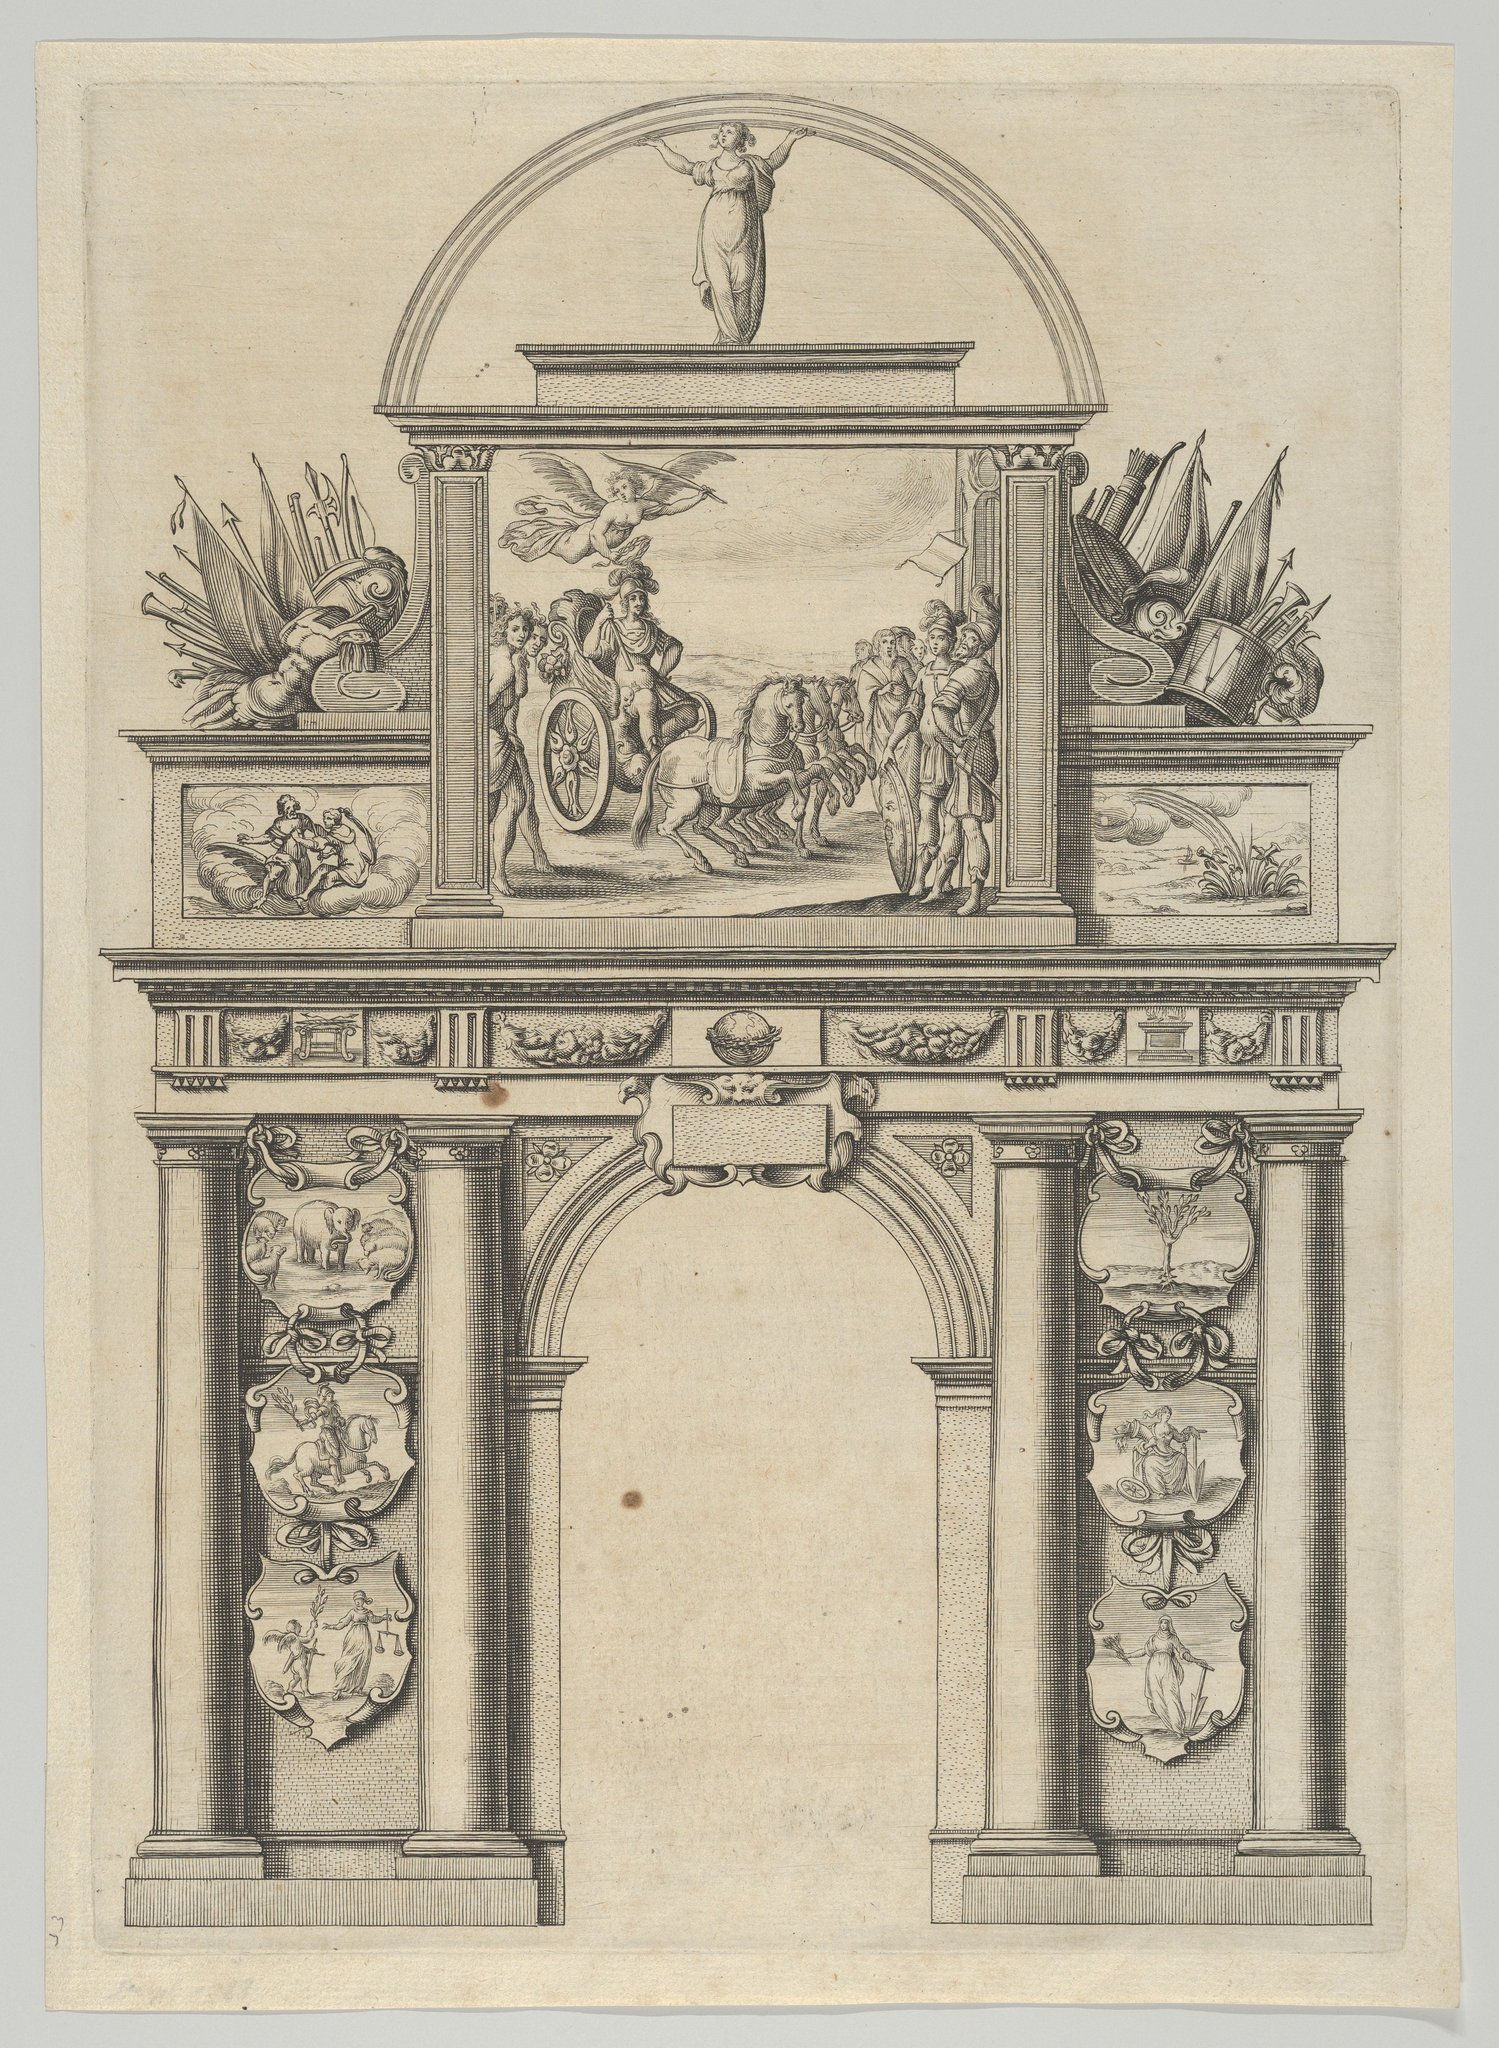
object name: print, fete, ornament architecture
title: Triumphal arch, from 'Éloges et discours sur la triomphante réception du Roy en sa ville de Paris ...' by Jean-Baptiste de Machault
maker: melchior tavernier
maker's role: artist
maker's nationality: french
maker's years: 1564-1641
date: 1629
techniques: etching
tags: architecture,arches,chariots